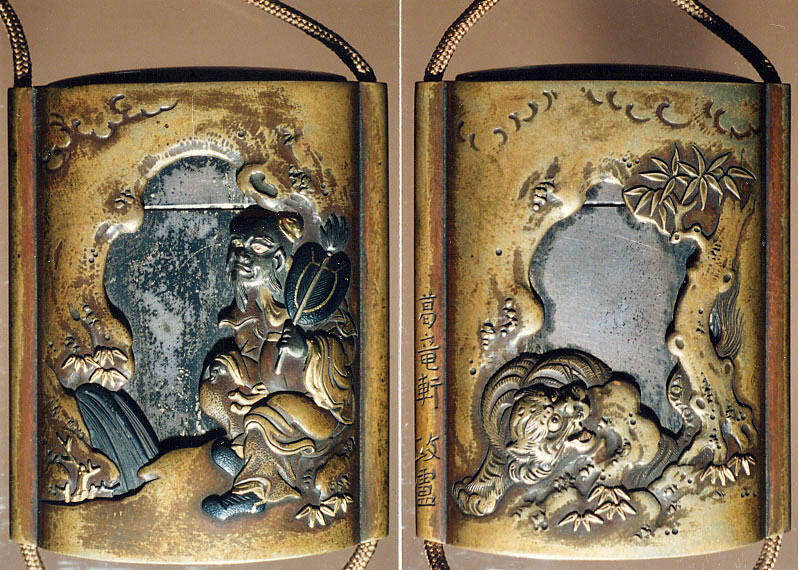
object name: inrō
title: Case (Inrō) with Design of Sage beside a Waterfall (obverse); Tiger beside Rocks and Maple Tree (reverse)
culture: japanese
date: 1701-1900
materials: brass, metal, silver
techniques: incising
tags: fans,men,tigers,trees